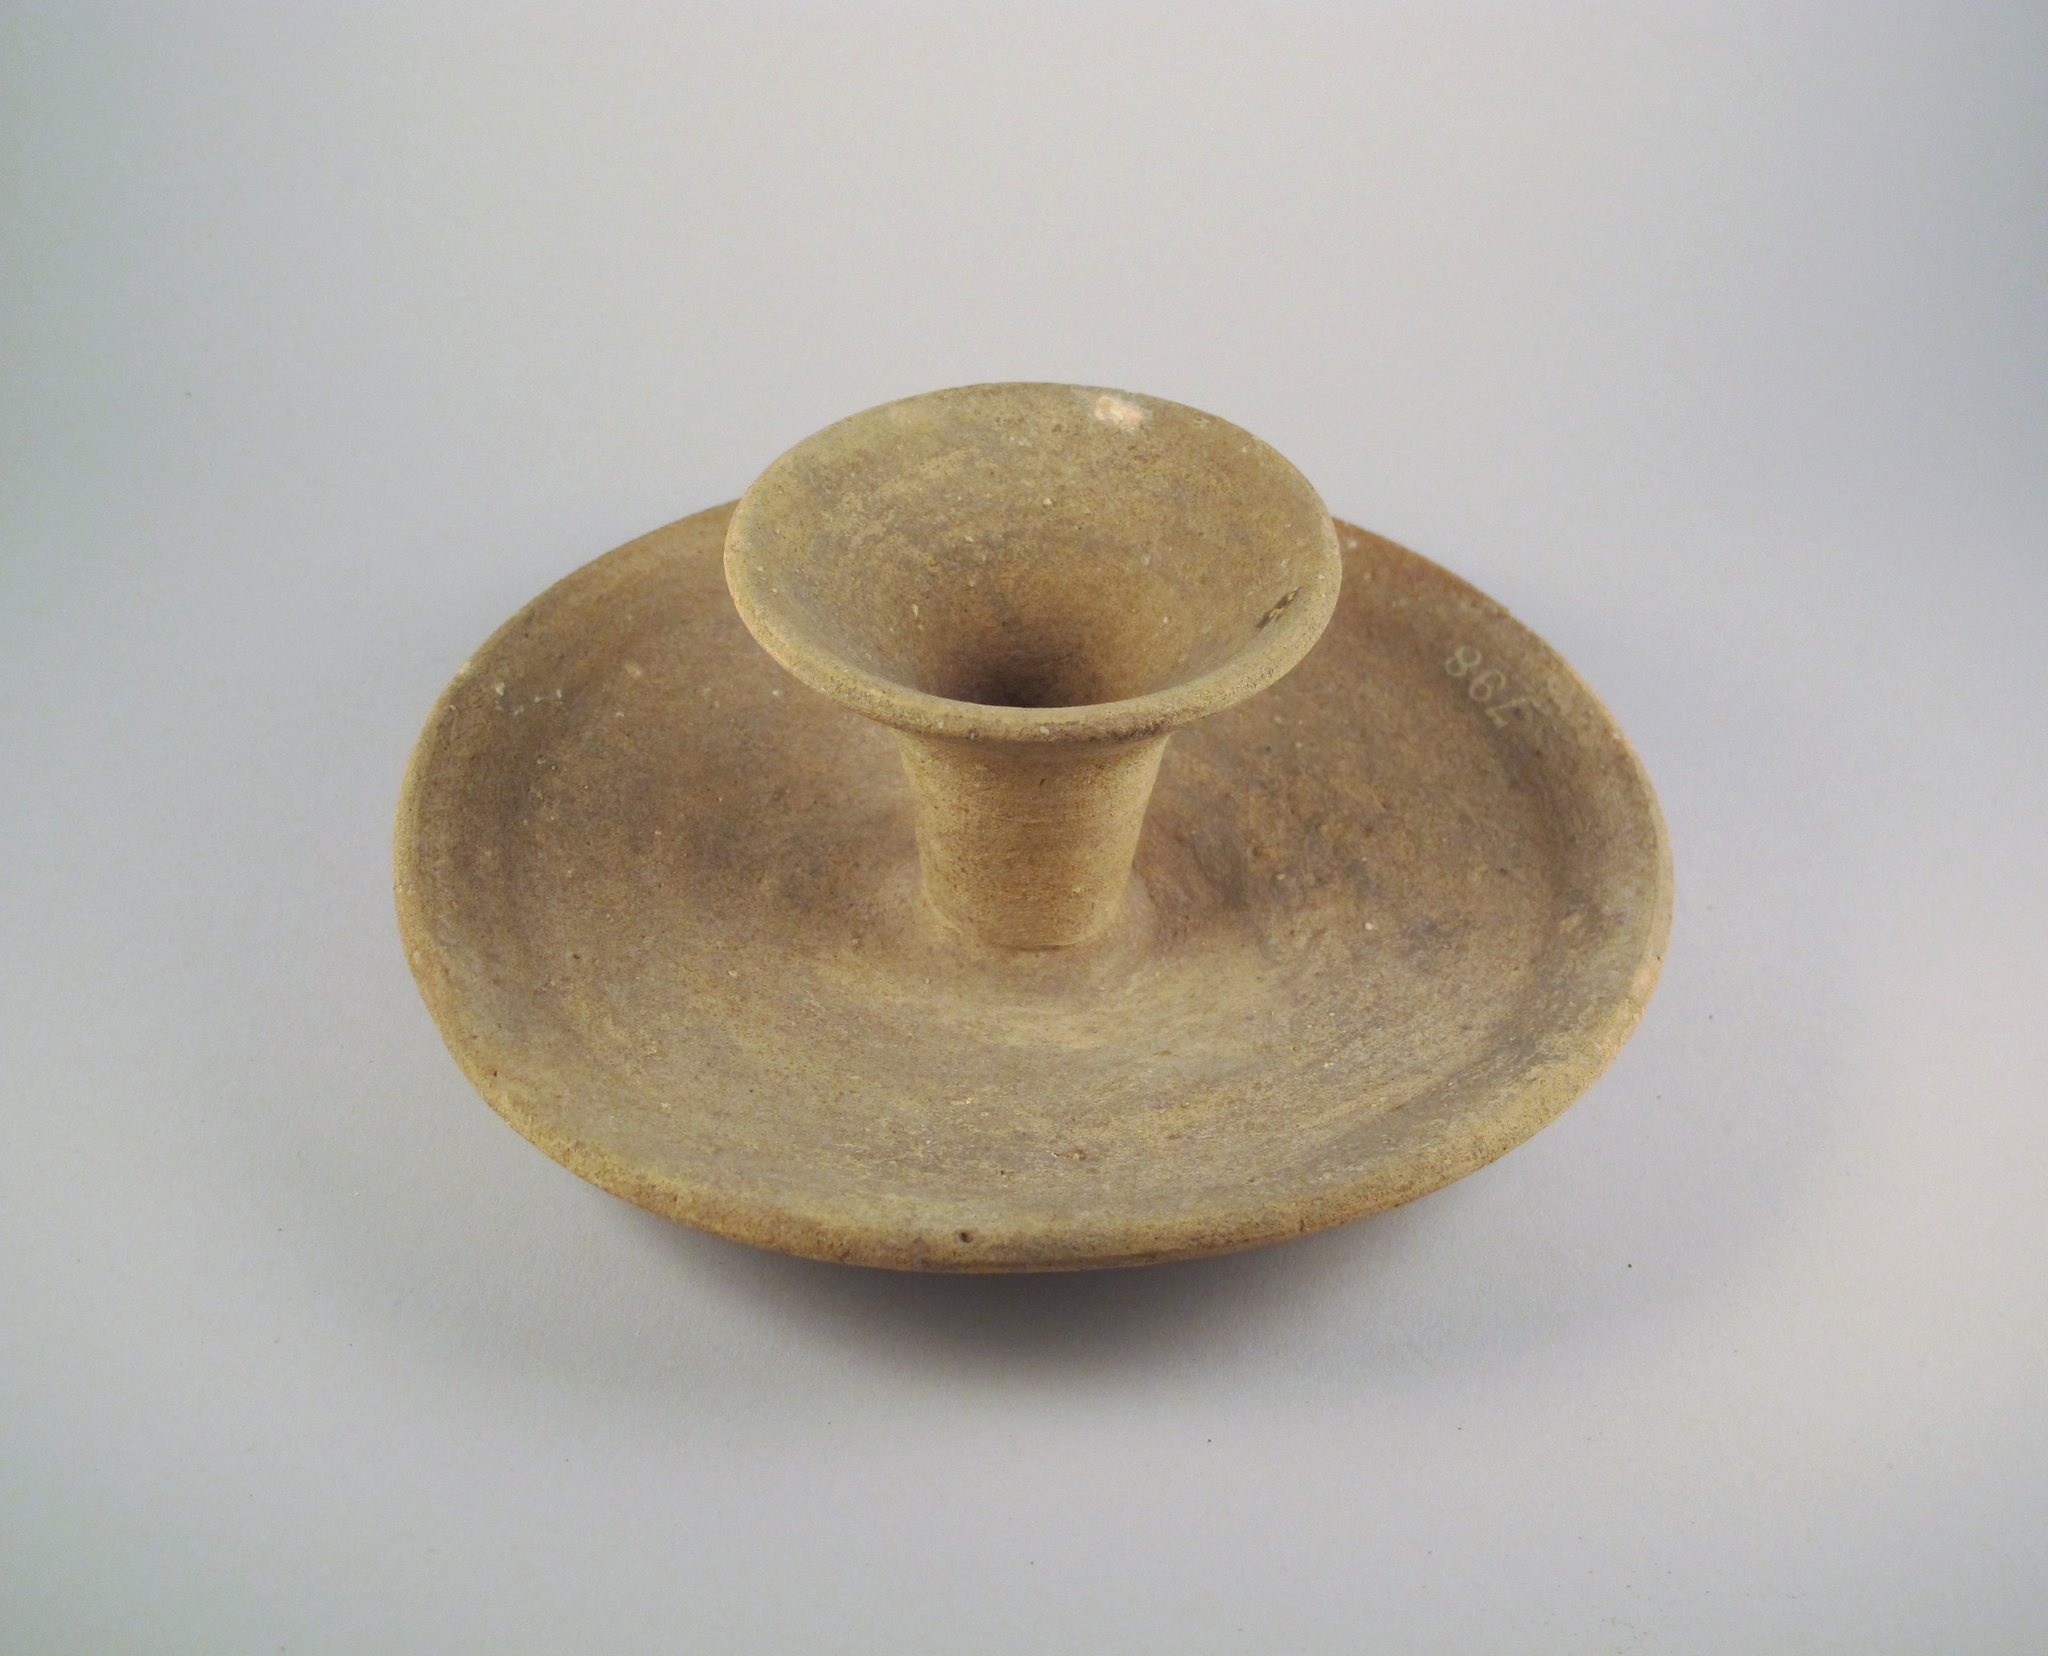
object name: torch holder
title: Torch-holder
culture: cypriot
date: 600-301 BCE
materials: terracotta